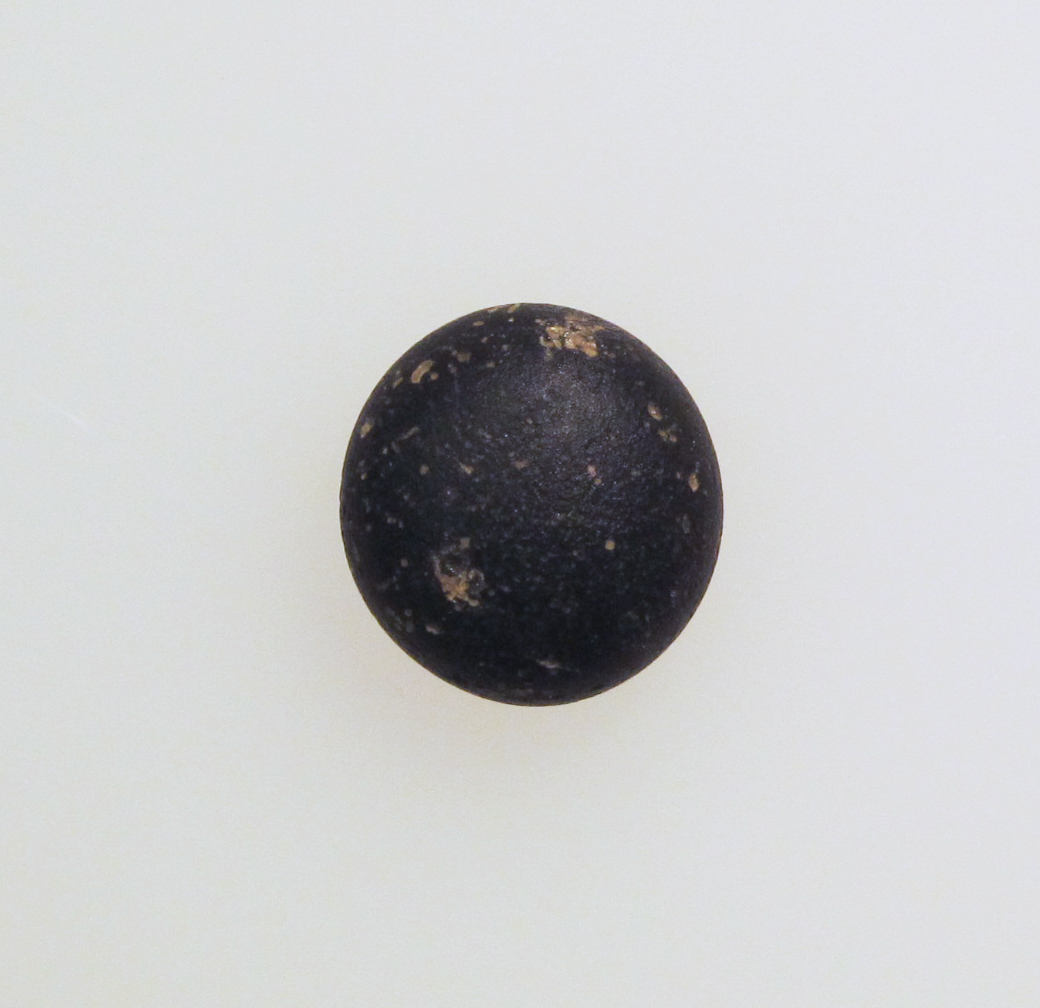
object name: pinhead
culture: roman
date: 100 BCE-500 CE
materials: glass